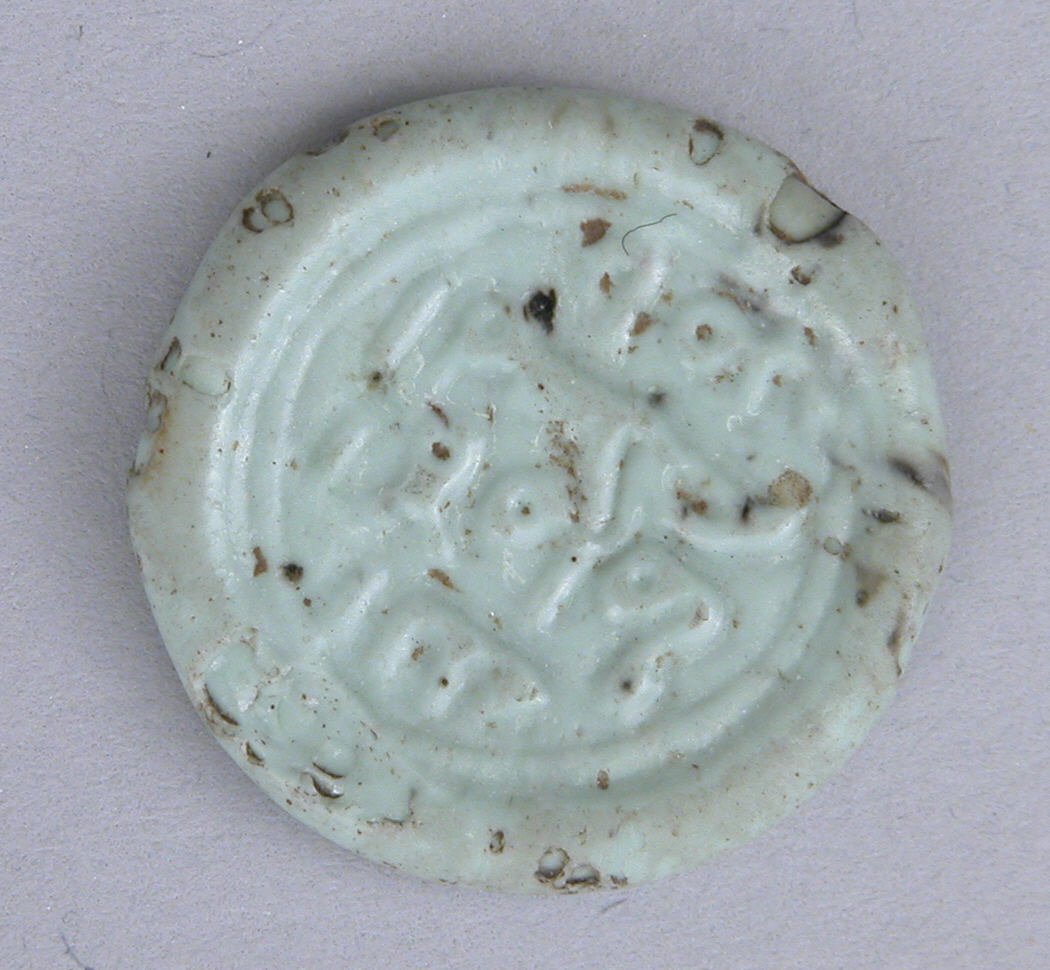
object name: coin weight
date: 1101-1200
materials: glass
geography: egypt